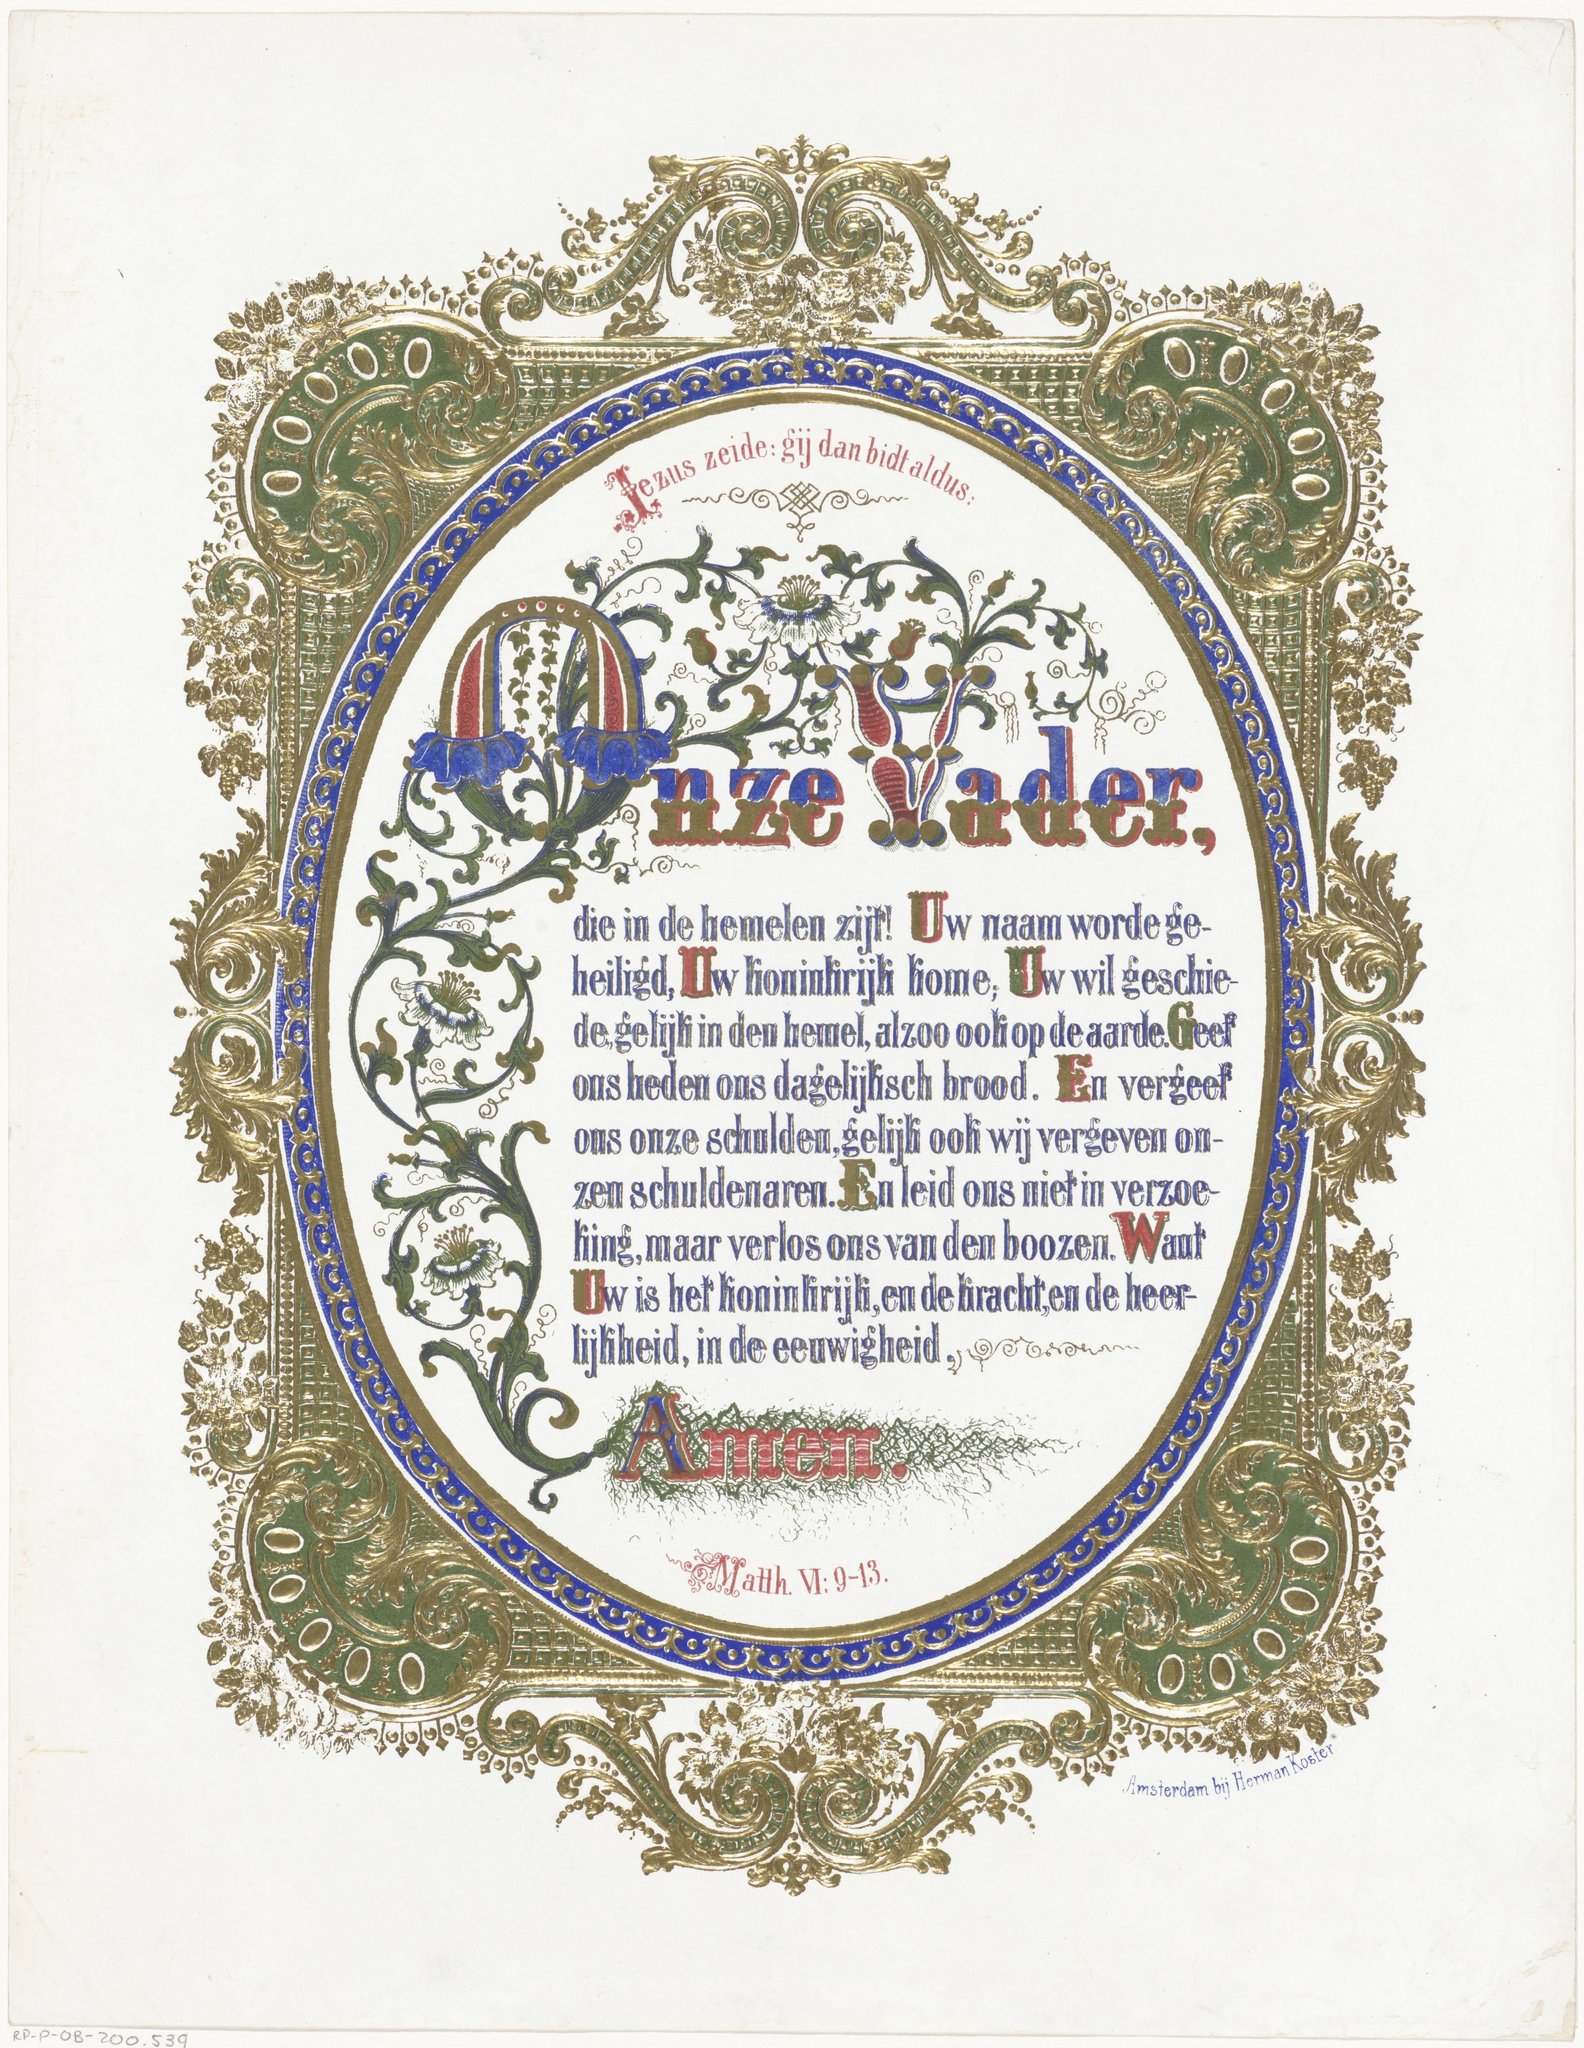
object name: print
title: Onze Vader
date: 1825-1847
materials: paper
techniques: blind stamped, letterpress printing, engraving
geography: amsterdam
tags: 'our father which art in heaven' ~ the lord's prayer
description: Het "Onze Vader" gebed (Matth. VI: 9-13) in boekdruk, in gouden sierlijst.